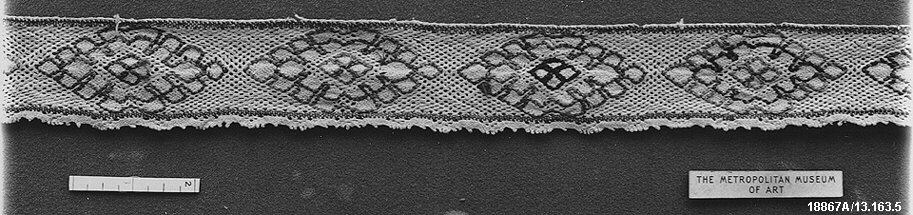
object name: fragment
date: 1601-1800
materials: linen, silk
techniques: lace